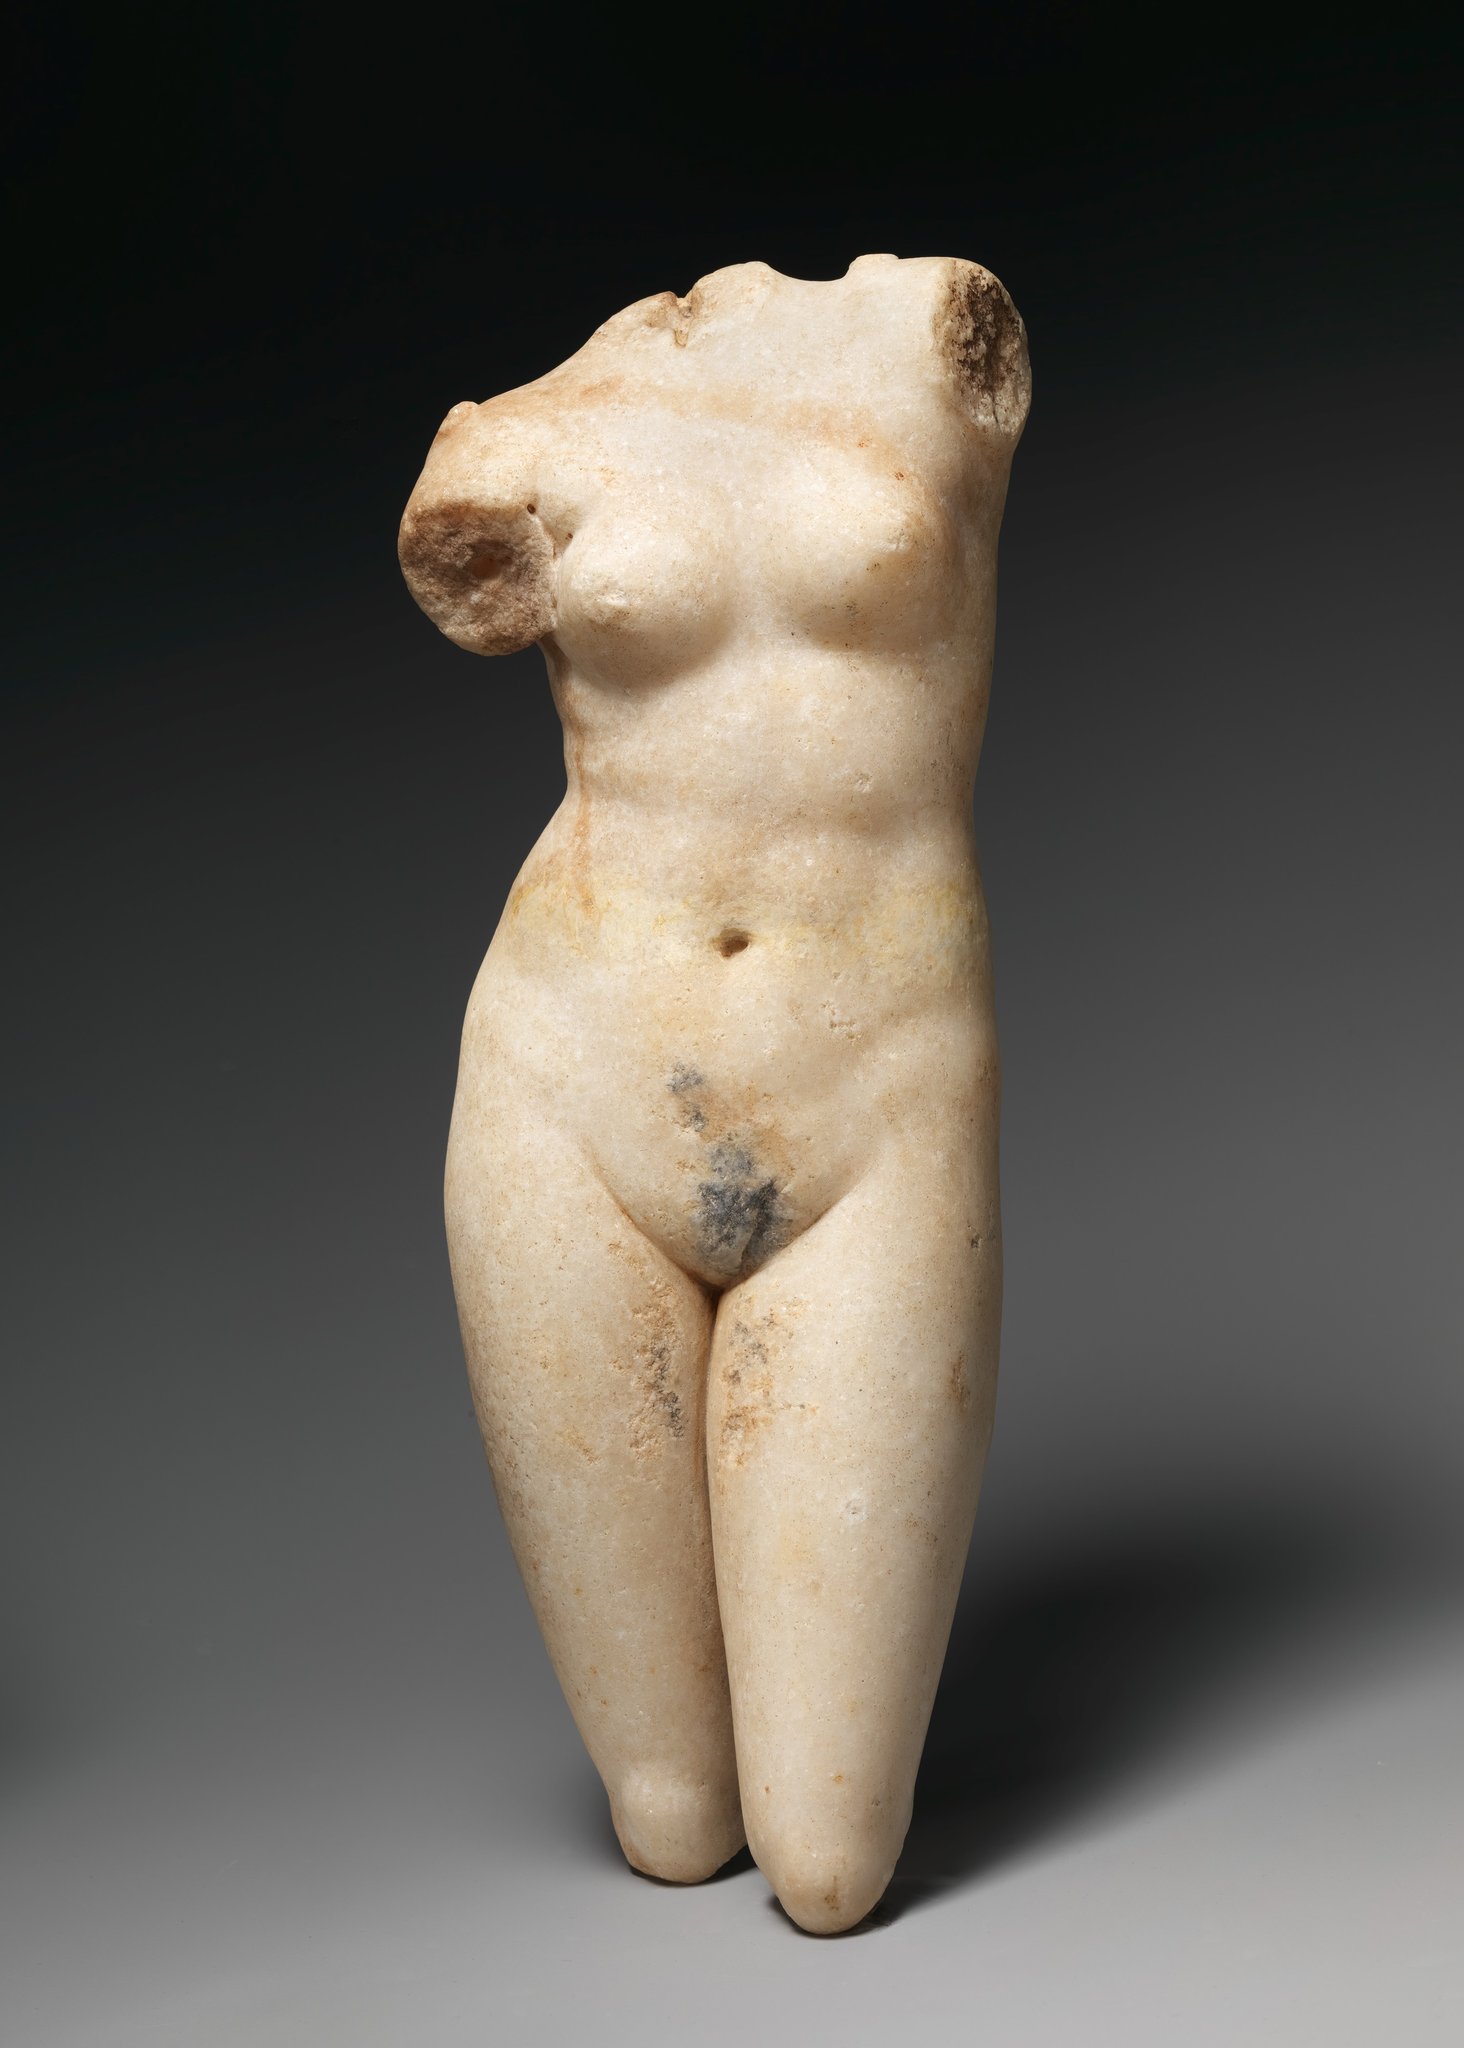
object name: statuette of aphrodite anadyomene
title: Marble statuette of Aphrodite Anadyomene (rising)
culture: roman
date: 1-100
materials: marble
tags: aphrodite